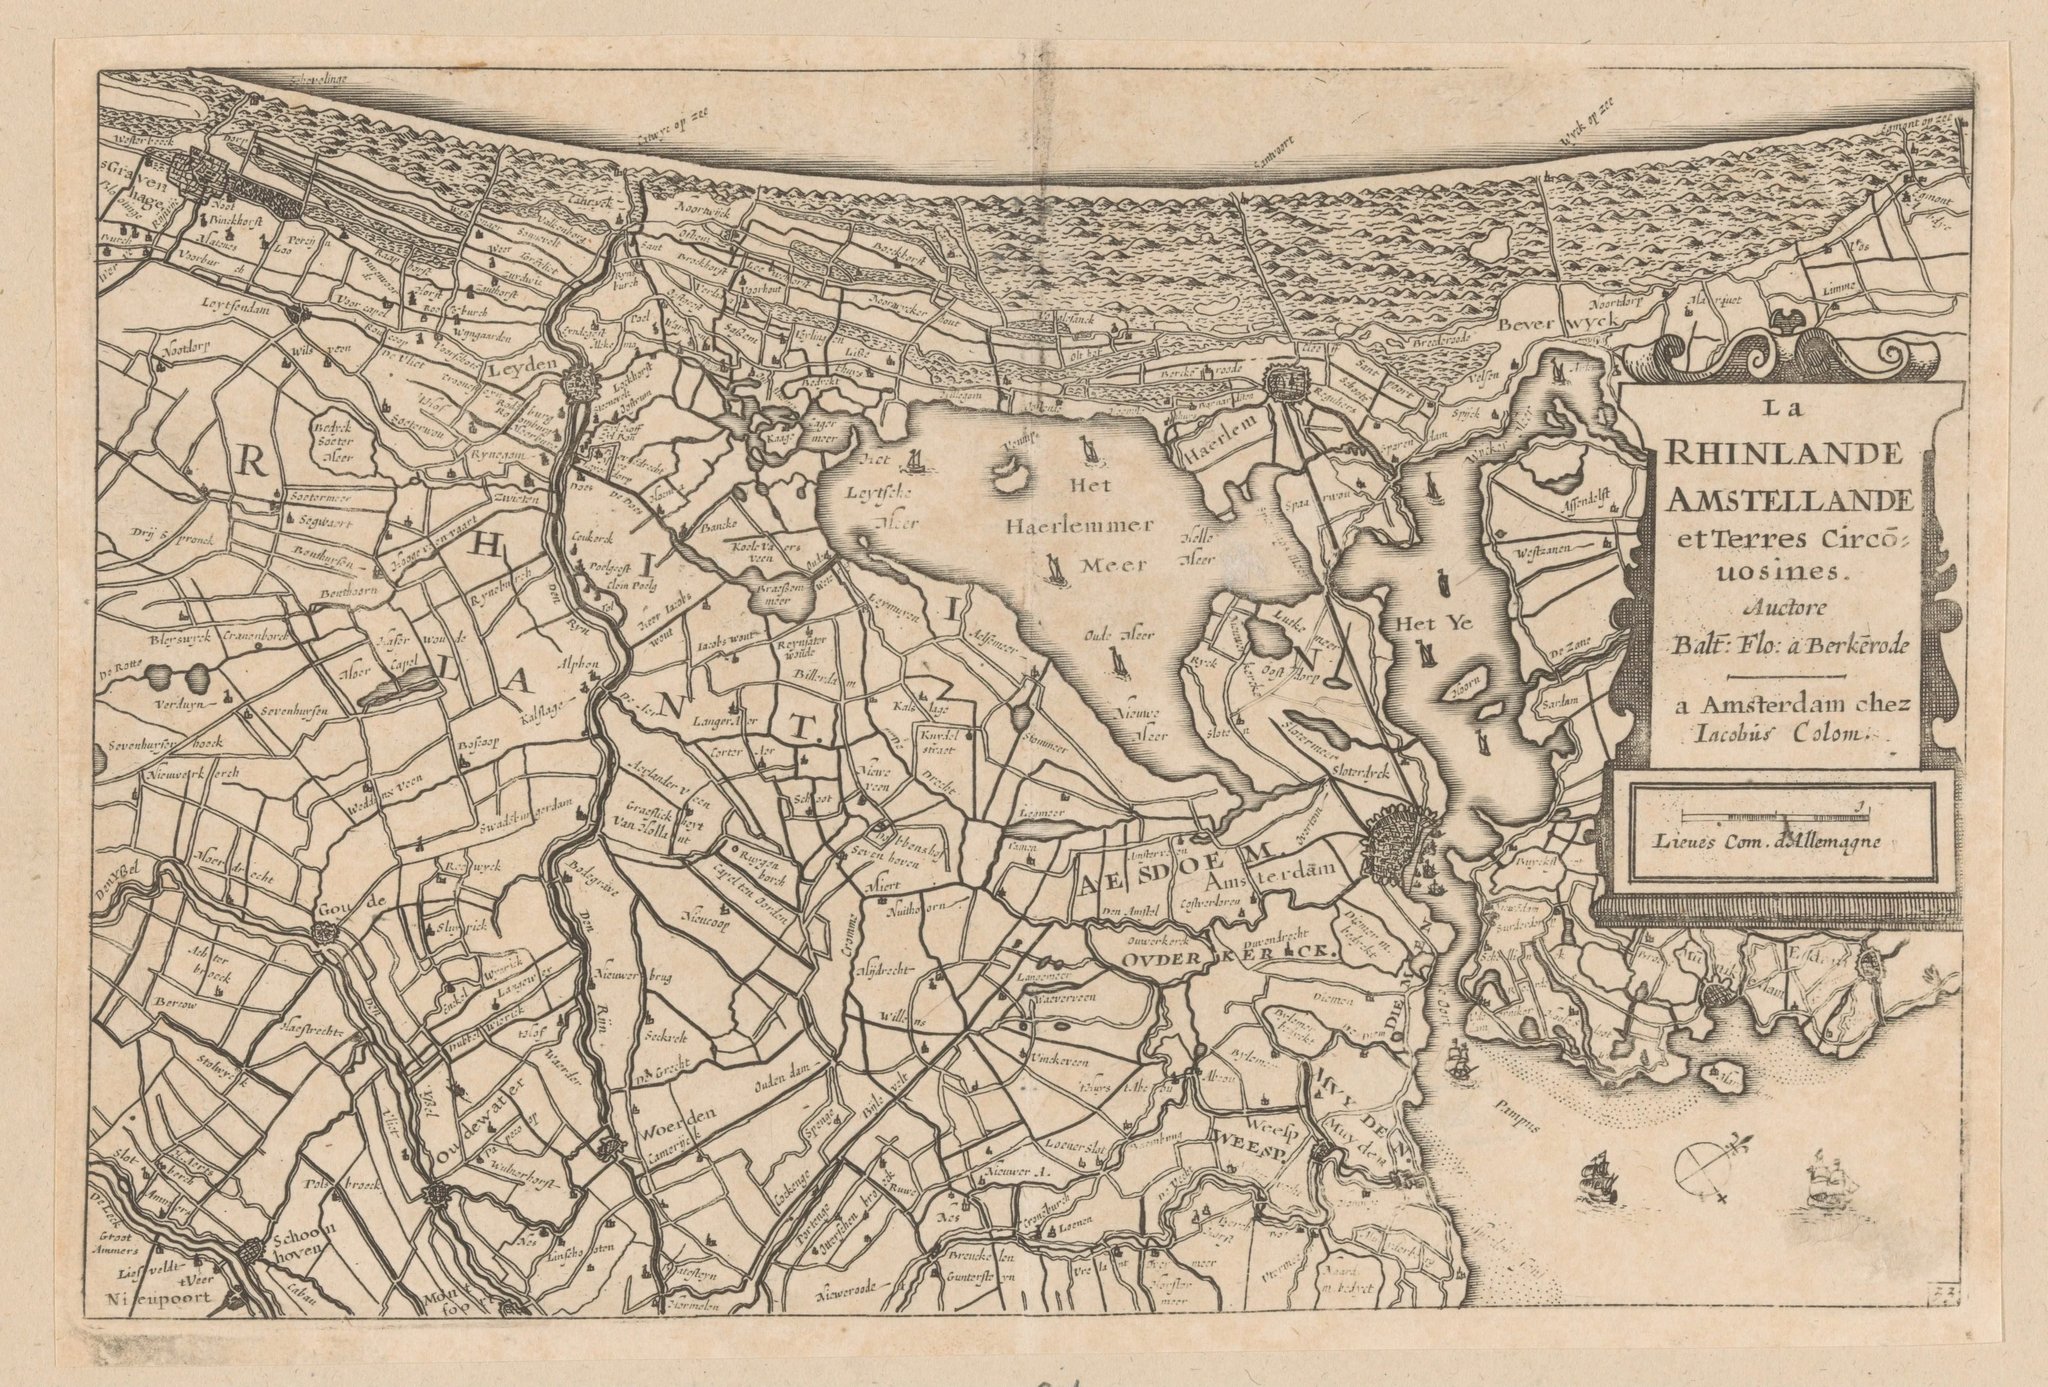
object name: map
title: La Rhinlande Amstellande et terres circouosines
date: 1635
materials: paper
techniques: engraving, etching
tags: maps of separate countries or regions, rhineland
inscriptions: collector's mark: Lugt 2228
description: Deze staat van prent ook gebruikt in: De vyerighe colom klaer vertoonende in vyftich onderscheydene curieuse caarten de XVII. Nederlantsche Provincien (…). Amsterdam: Jacob Aertsz Colom (I), s.a. [ca. 1660], tussen p. 130 en p. 131. En in latere uitgaven met de platen van deze publicatie, uitgegeven door Pieter van Alphen (1691) en Pieter van der Slaart (1696). Zie documentatie voor meer informatie. Eerdere staat van prent (zonder ‘33’ rechtsonder) ook gebruikt in eerdere drukken van deze publicatie.